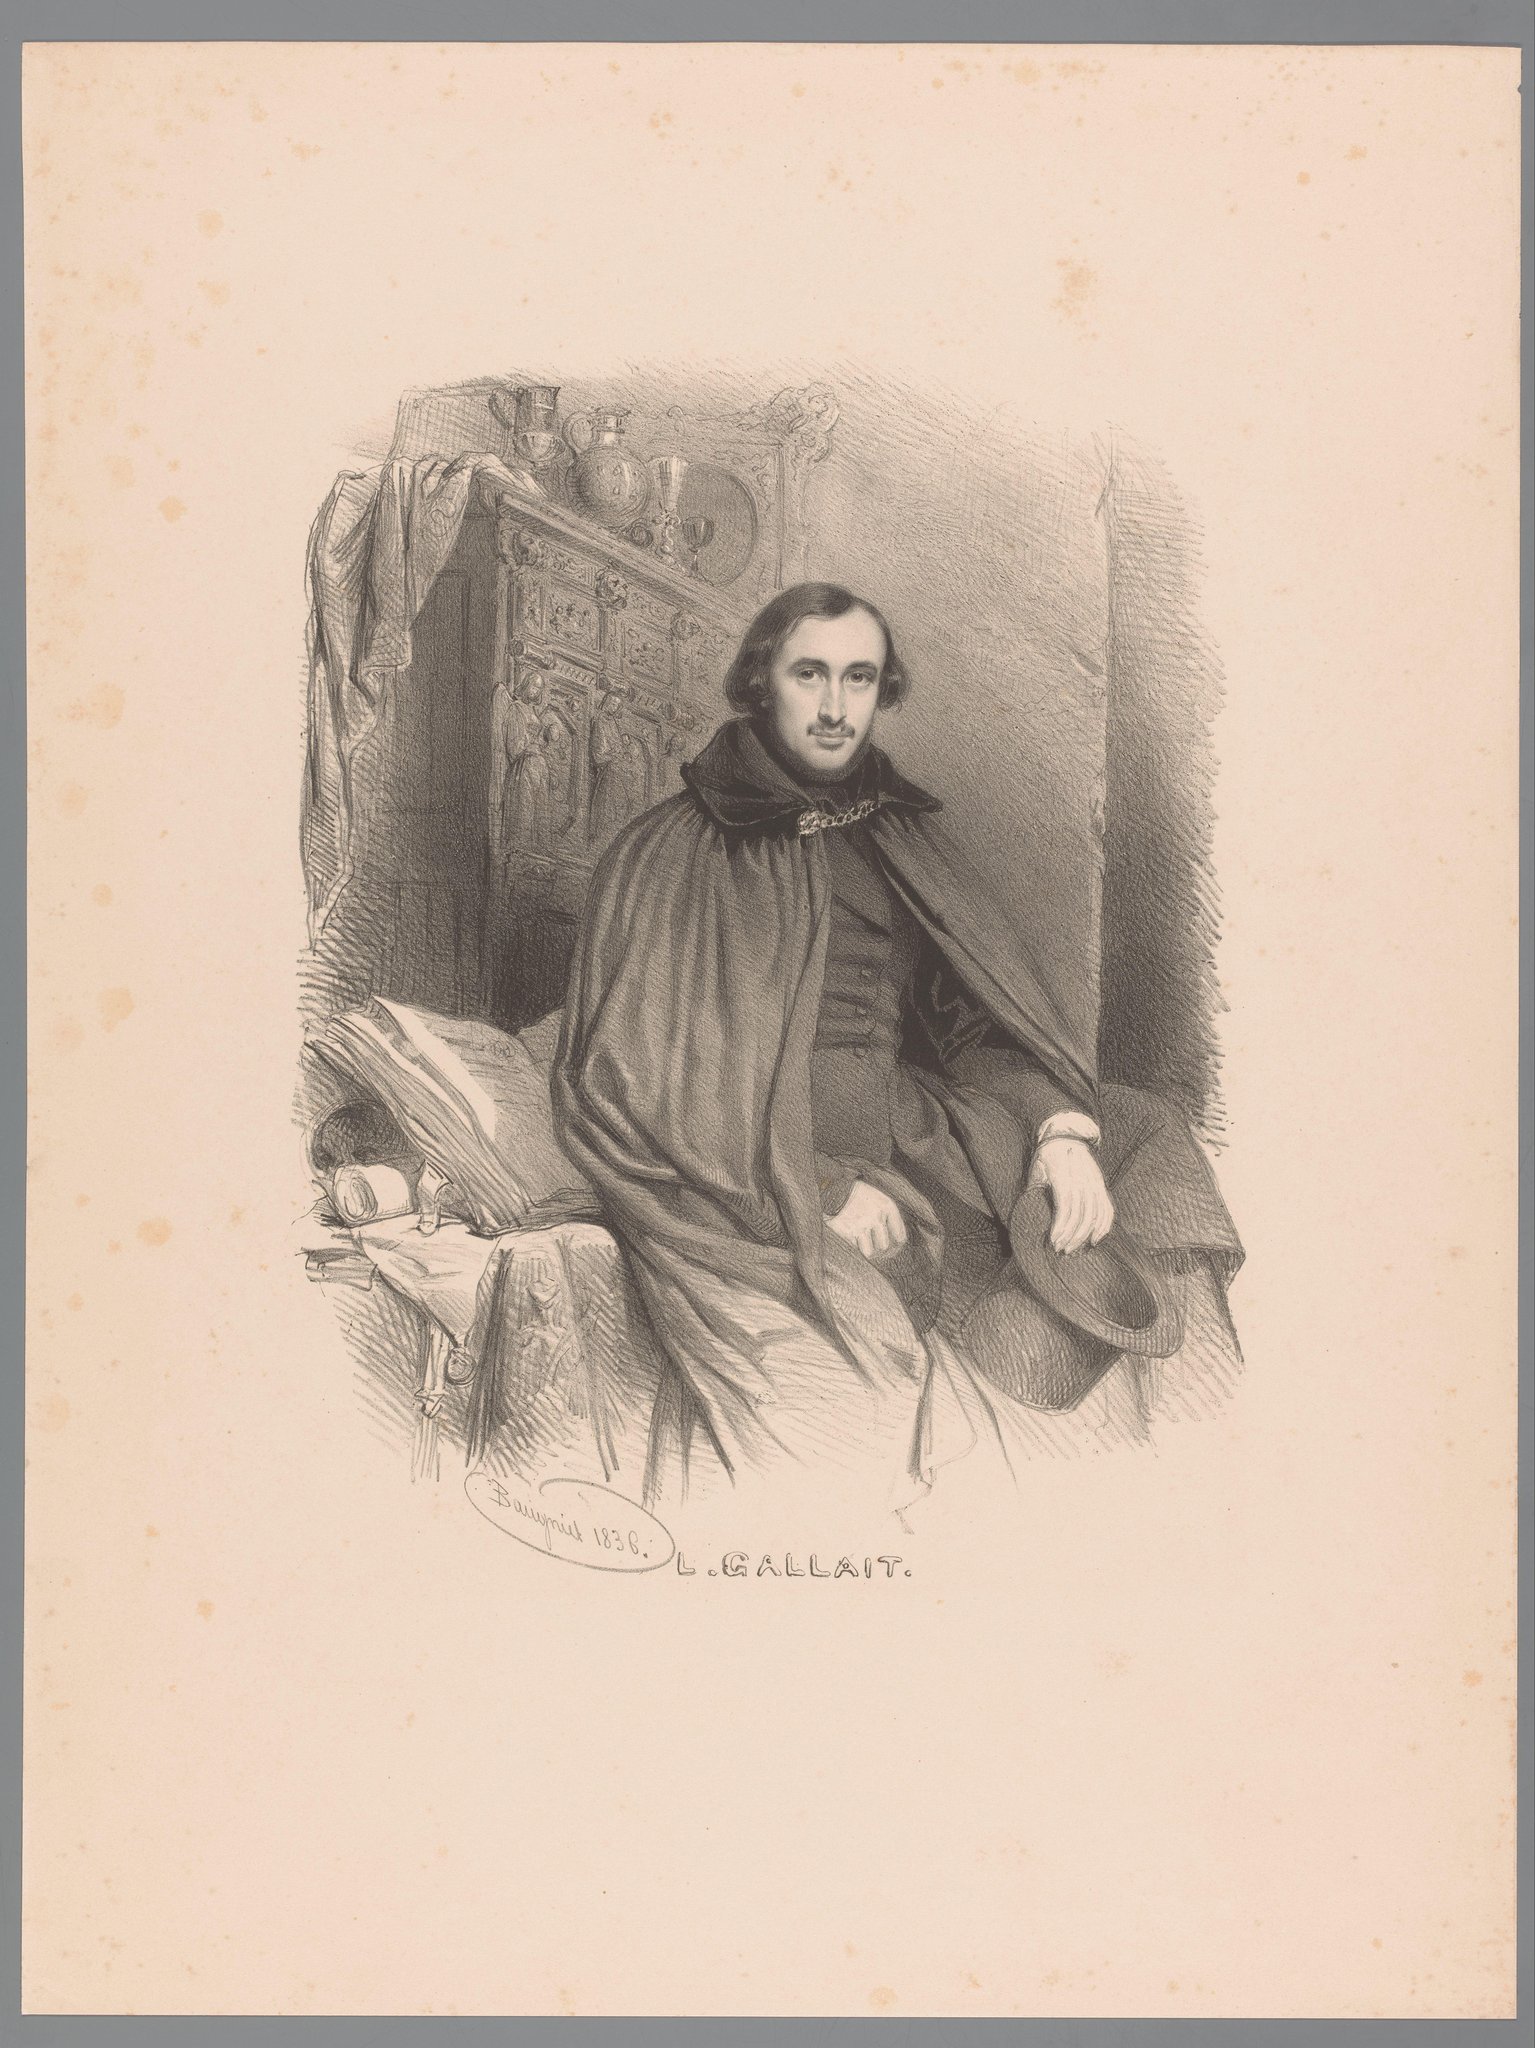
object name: print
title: Portret van Louis Gallait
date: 1836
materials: paper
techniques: lithograph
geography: brussels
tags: painter, print maker, draughtsman, louis gallait, adult man, historical persons, book - mm - book open, interior of the house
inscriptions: collector's mark: Lugt 2228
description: Prent verschenen in: Baugniet, Charles. Les artistes contemporains: portraits lithographiés d'après nature, accompagnés de notices sur la vie et les ouvrages de chacun d'eux. Brussel: De Wasme-Pletinckx, [1836-1840].